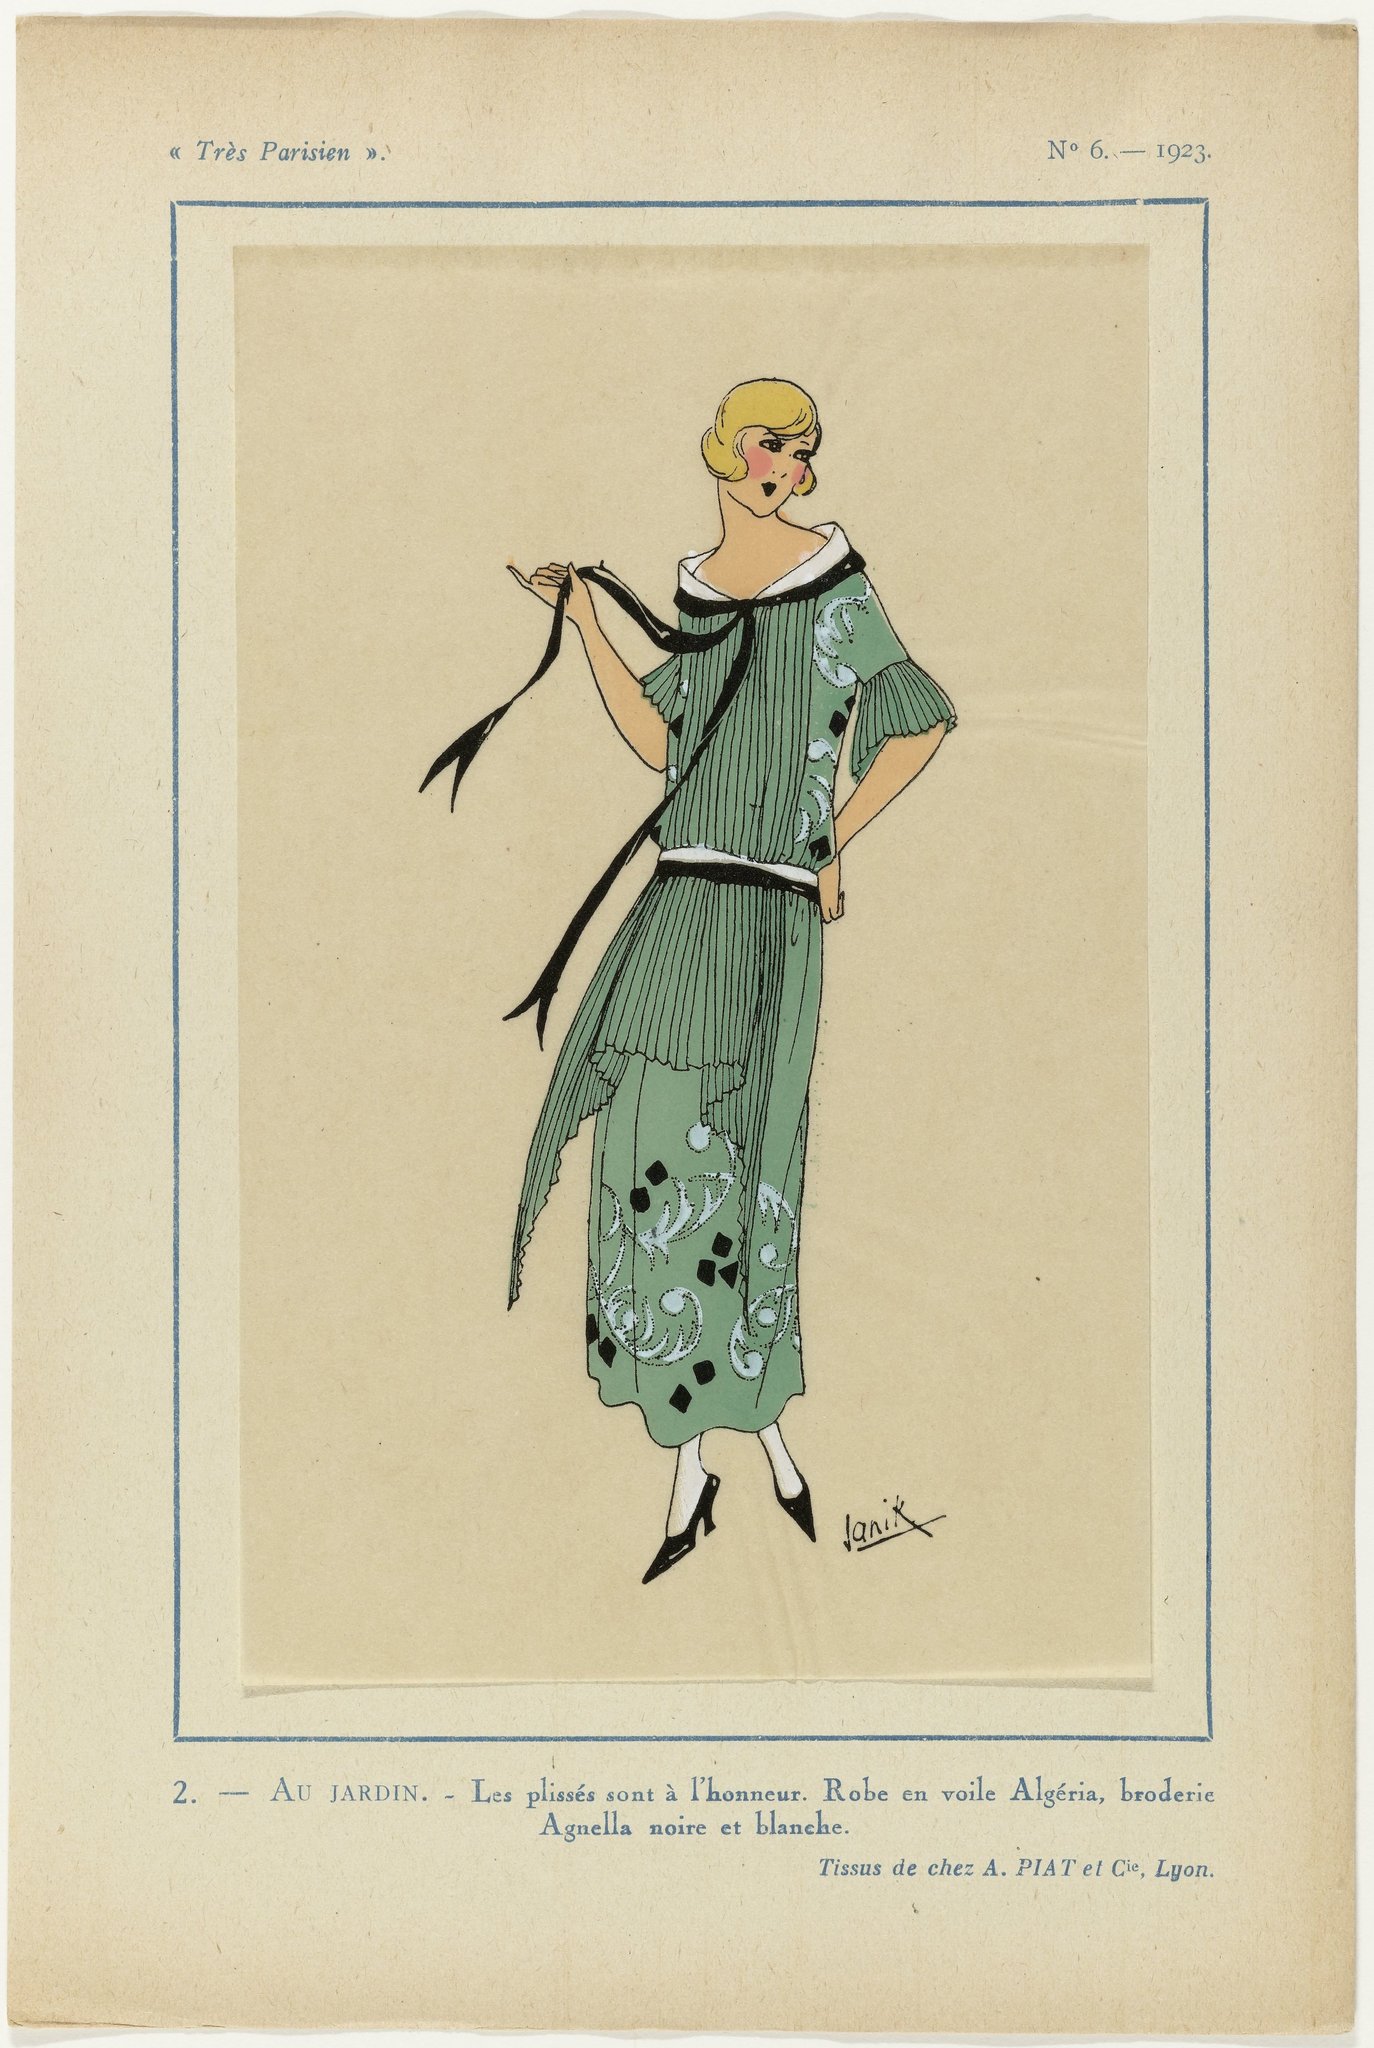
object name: fashion print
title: Très Parisien, 1923, No 6: 2.- AU JARDIN. / Les plissés sont à l'honneur...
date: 1923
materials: paper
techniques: hand coloring, letterpress printing, lithography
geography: lyon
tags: embroidery (ornamentation) (+ women's clothes), border, ribbon, braid (+ women's clothes), fashion plates, head-gear: hat (+ women's clothes), dress, gown (+ women's clothes)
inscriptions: caption: ‘2. - AU JARDIN. - Les plissés sont à l'honneur. Robe en voile Algéria, broderie Agnella noire et blanche. / Tissus de chez A. PIAT et Cie, Lyon.’, title: ‘Très Parisien / No 6. - 1923’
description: Jurk van voile Algéria, borduurwerk Agnella in zwart en wit. Volgens het onderschrift ligt de nadruk op de plooien(?). Stoffen van A. Piat et Cie. Prent uit het modetijdschrift Très Parisien (1920-1936).